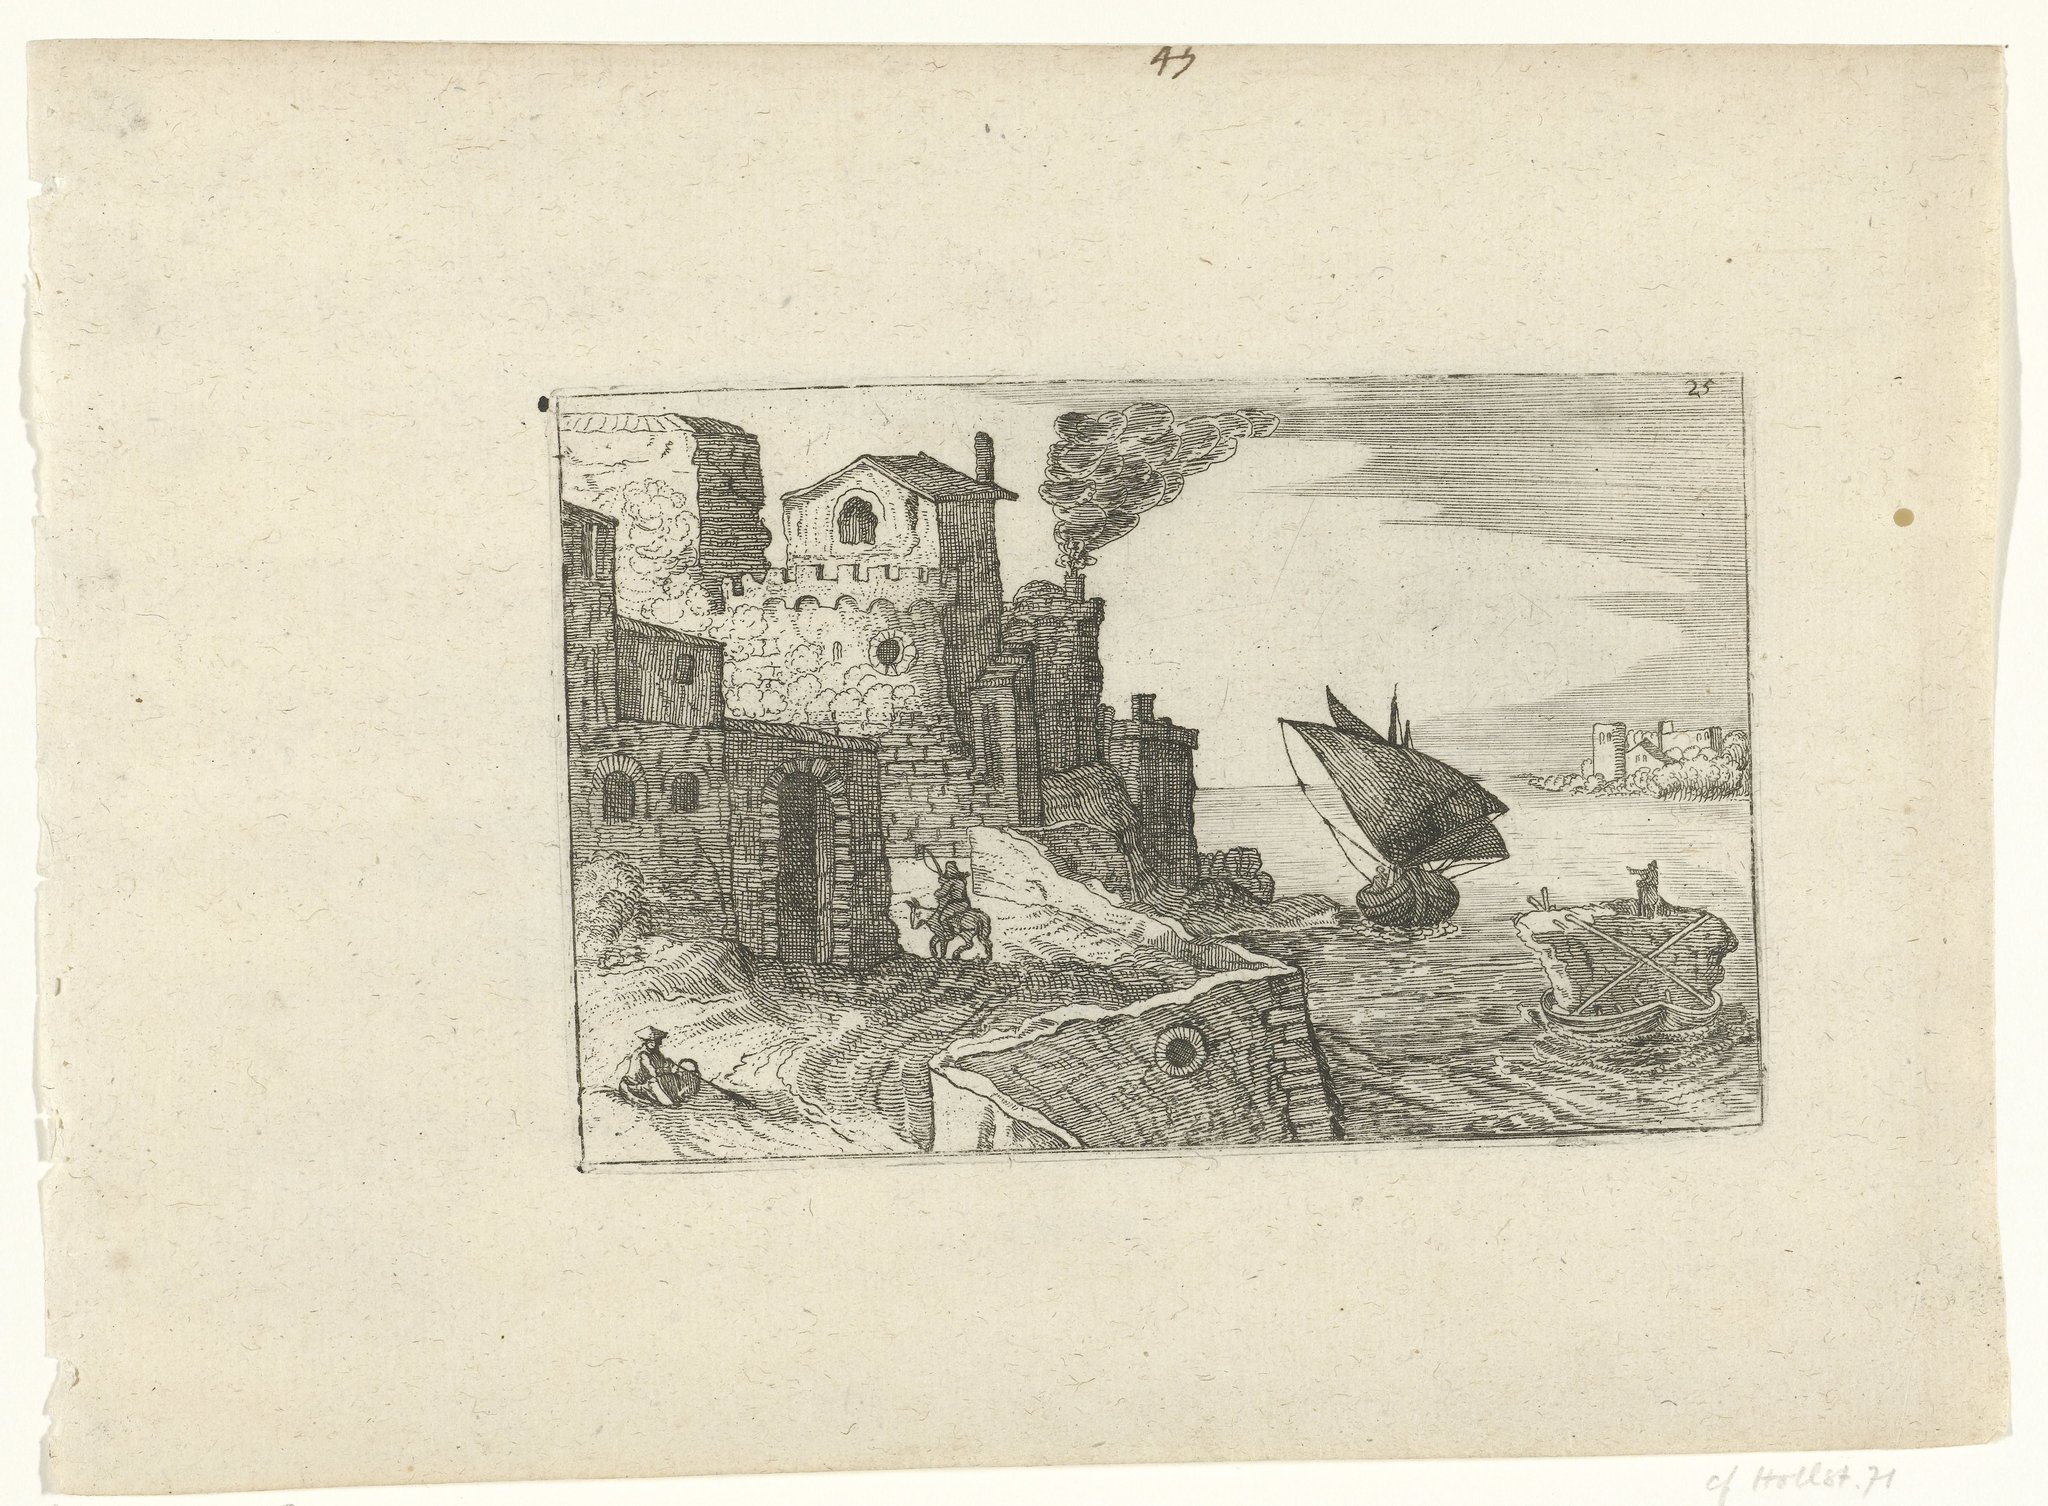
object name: print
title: Kustdorp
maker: Anonymous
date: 1594-1685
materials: paper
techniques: etching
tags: sailing-ship, sailing-boat, village street, merchant shipping, shipping trade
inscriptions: collector's mark: Lugt 2228, collector's mark: Lugt 2760, inscription: ‘45’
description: Links een dorp met een kademuur. Op een weg loopt een bereden ezel en zit een figuur. Vanaf zee komt een zeilschip en een schuit met lading aanvaren. Prent maakt deel uit van een serie Romeinse ruïnes en kustlandschappen naar prenten van Willem van Nieulandt. Deze serie is een kopie van de serie, die Claes Jansz Visscher naar Van Nieulandt maakte.